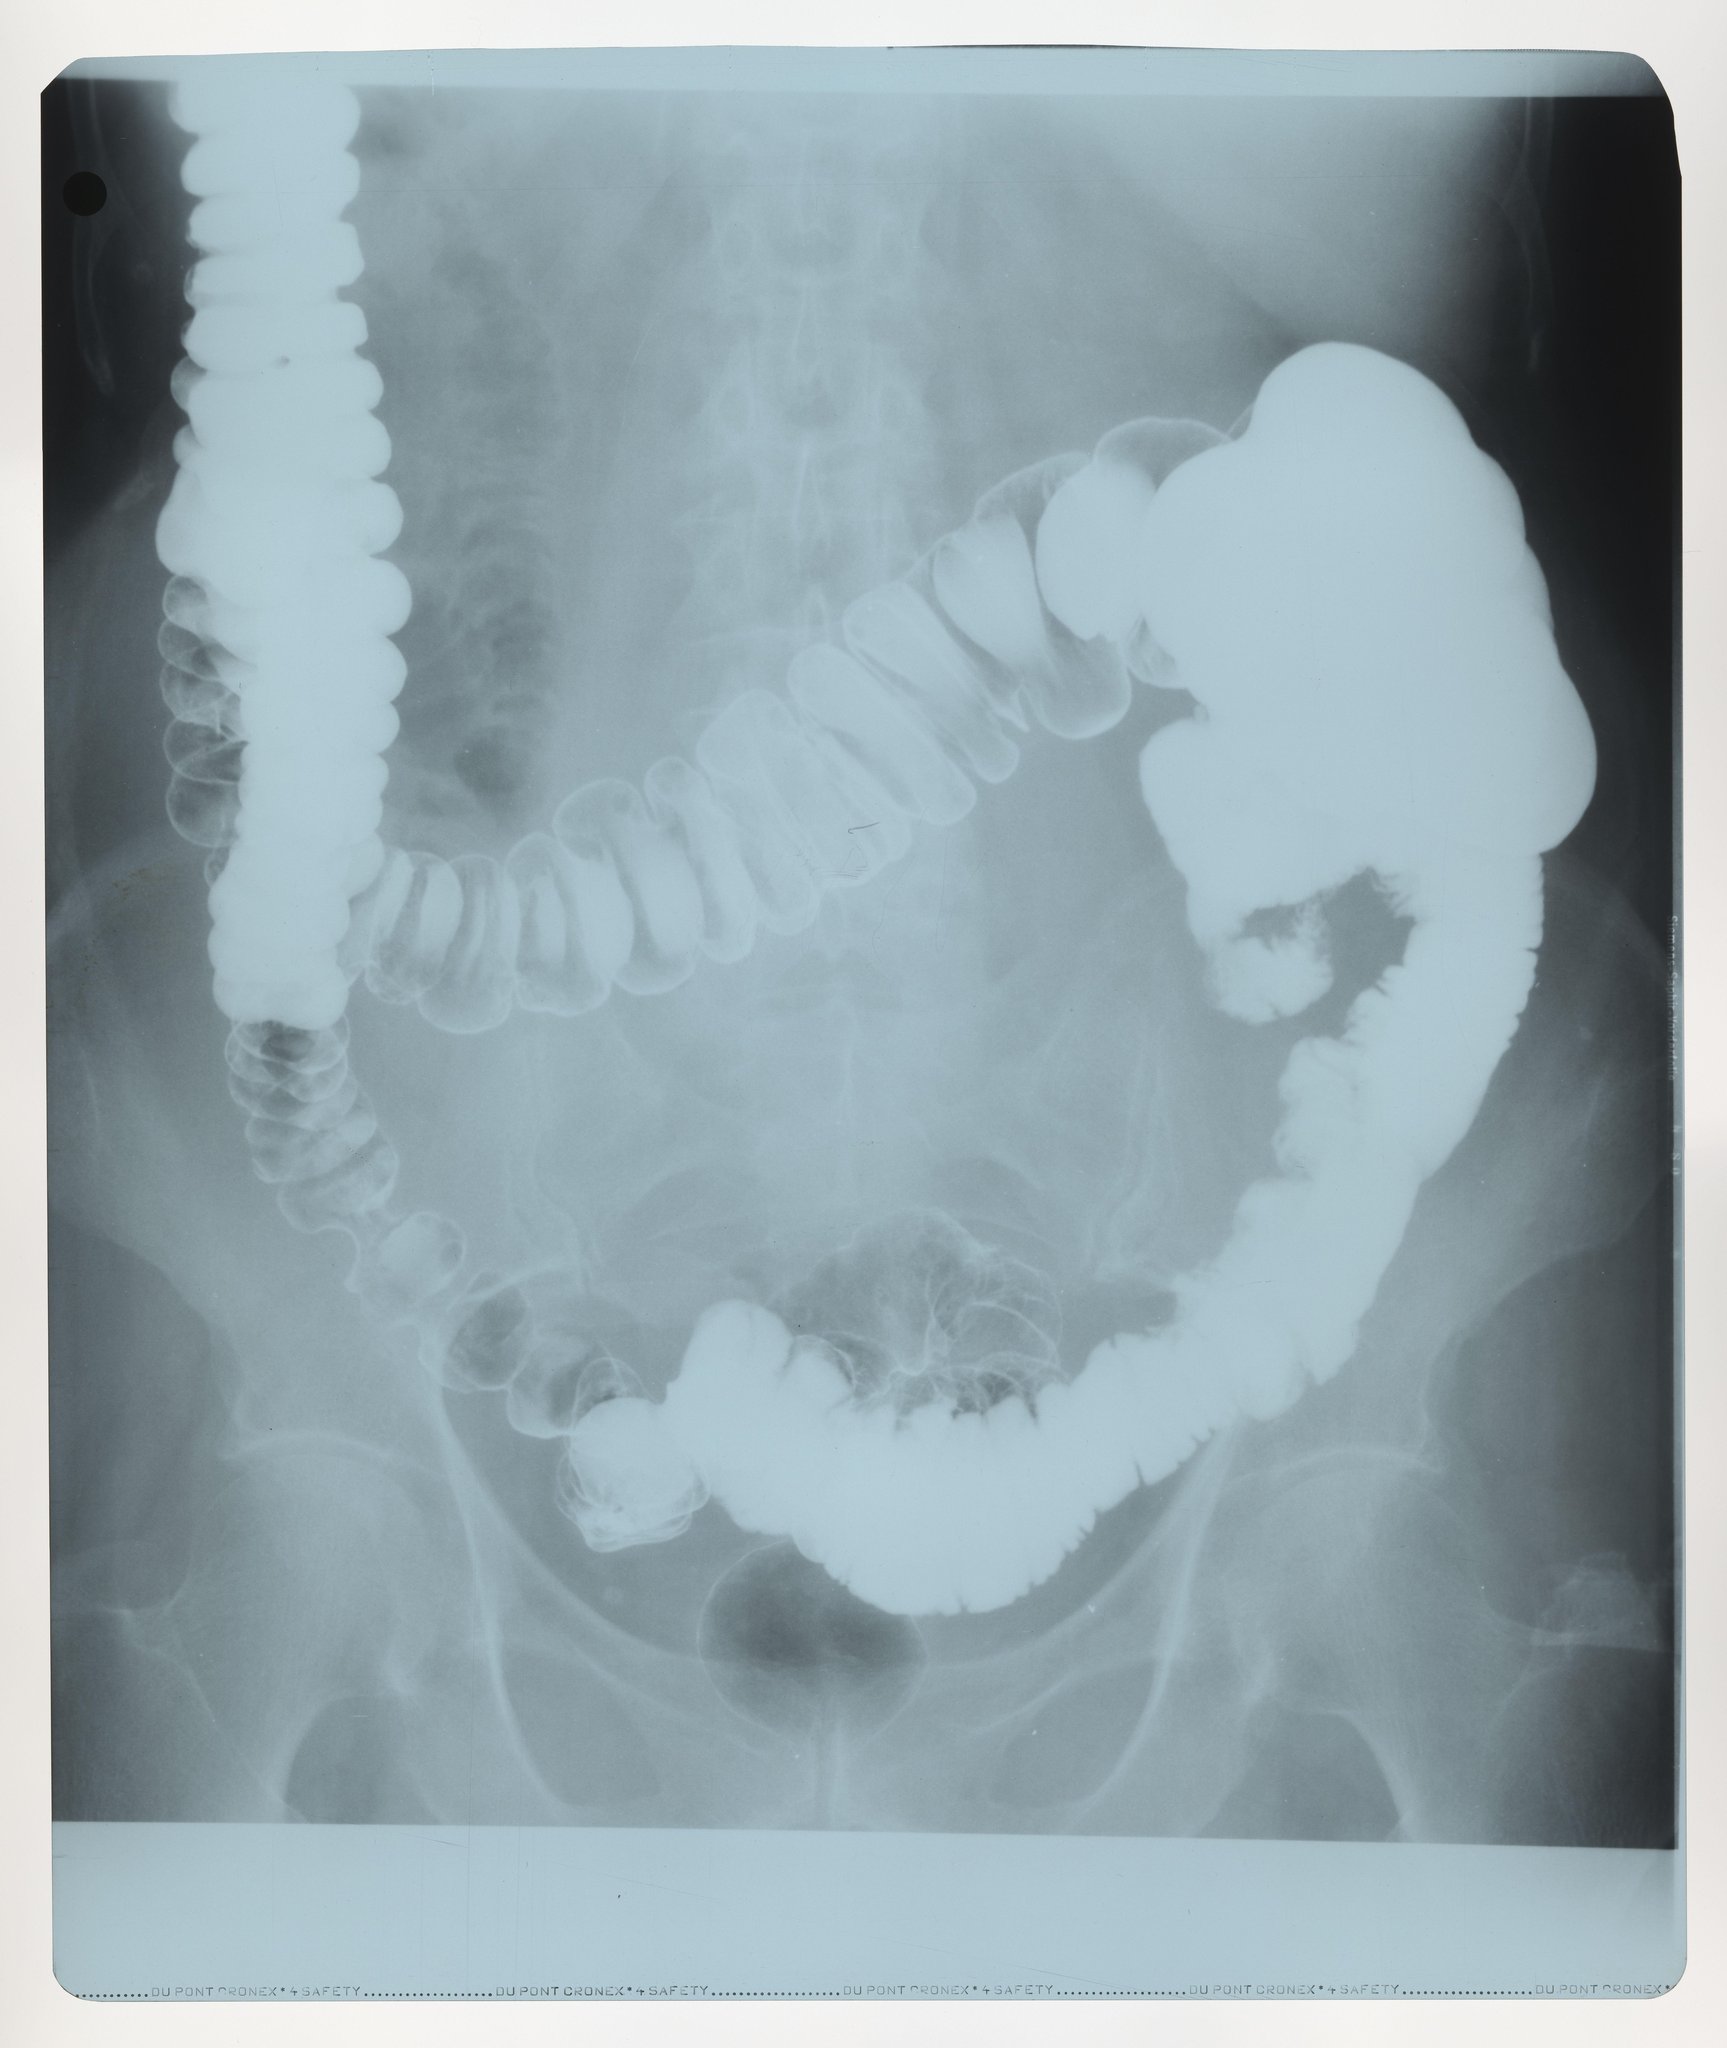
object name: x ray photograph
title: Röntgenopname van een menselijke dikke darm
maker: Anonymous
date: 1910-1980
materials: plastic, film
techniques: gelatin silver negative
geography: amsterdam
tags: intestines